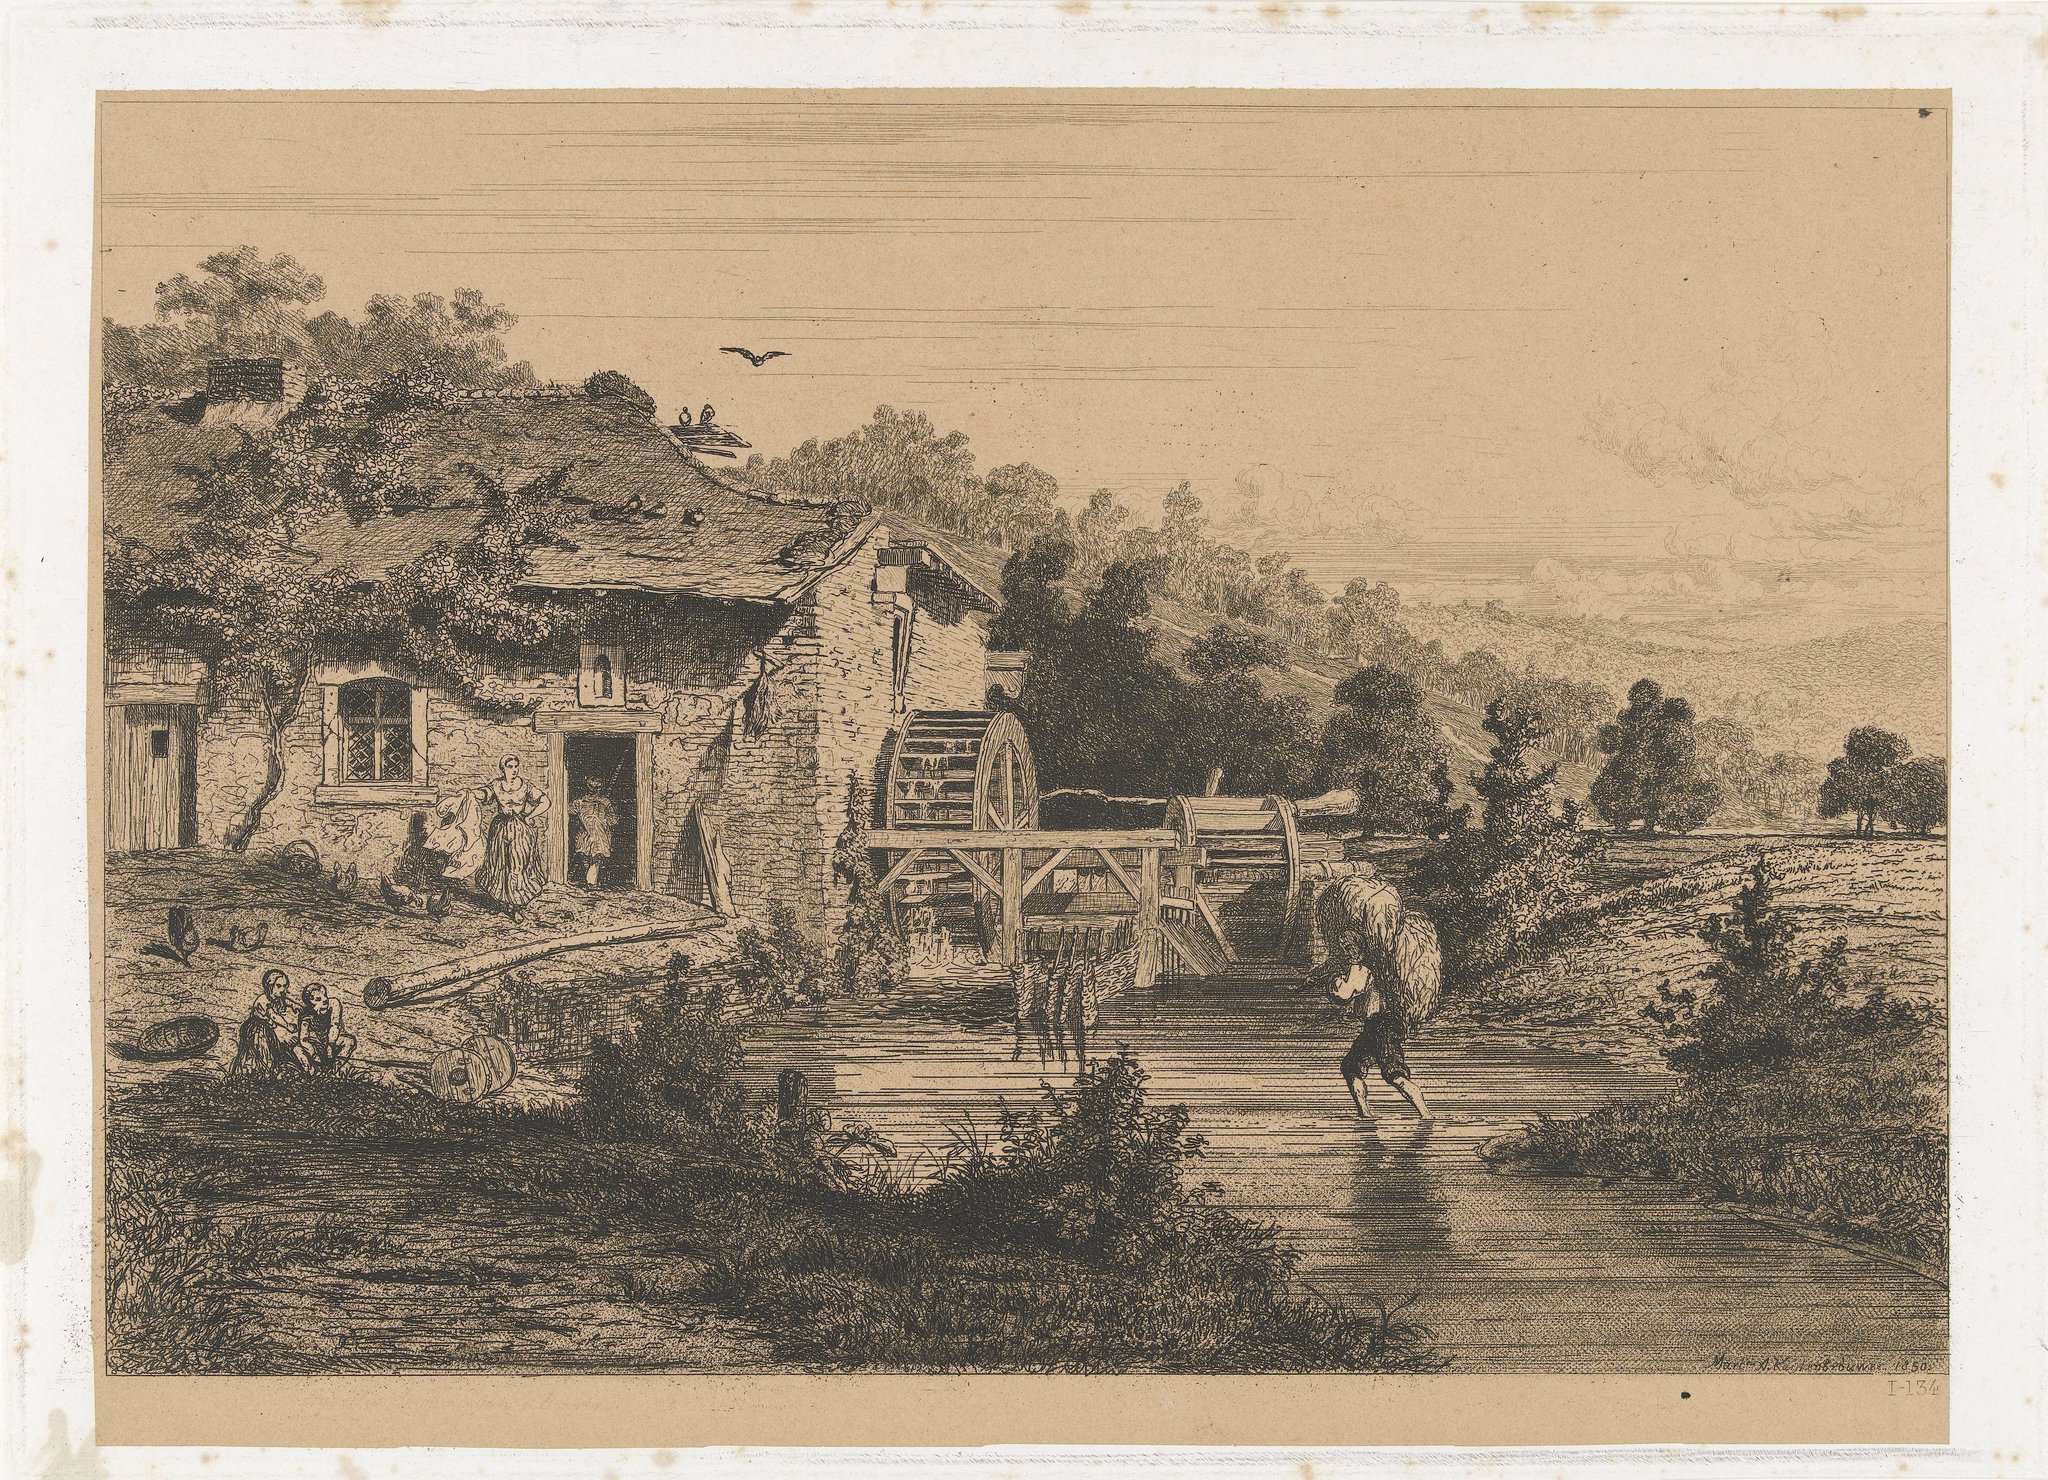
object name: print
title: Watermolen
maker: martinus antonius kuytenbrouwer jr.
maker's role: draughtsman, painter, print maker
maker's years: 1821-1897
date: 1850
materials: paper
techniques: etching, intaglio, roulette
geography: brussels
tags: agricultural products and by-products: hay, farmers - aa - female farmer, farmer's wife, brook, fowl (cock, hen, chicken, etc.), watermill in landscape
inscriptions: collector's mark: Lugt 2228, collector's mark: Lugt 1485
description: Landschap met een watermolen aan een beek. In de beek loopt een man met een baal hooi op zijn rug. Op het erf voor de molen staat een boerin en lopen een paar kippen. Aan de waterkant twee spelende kinderen.